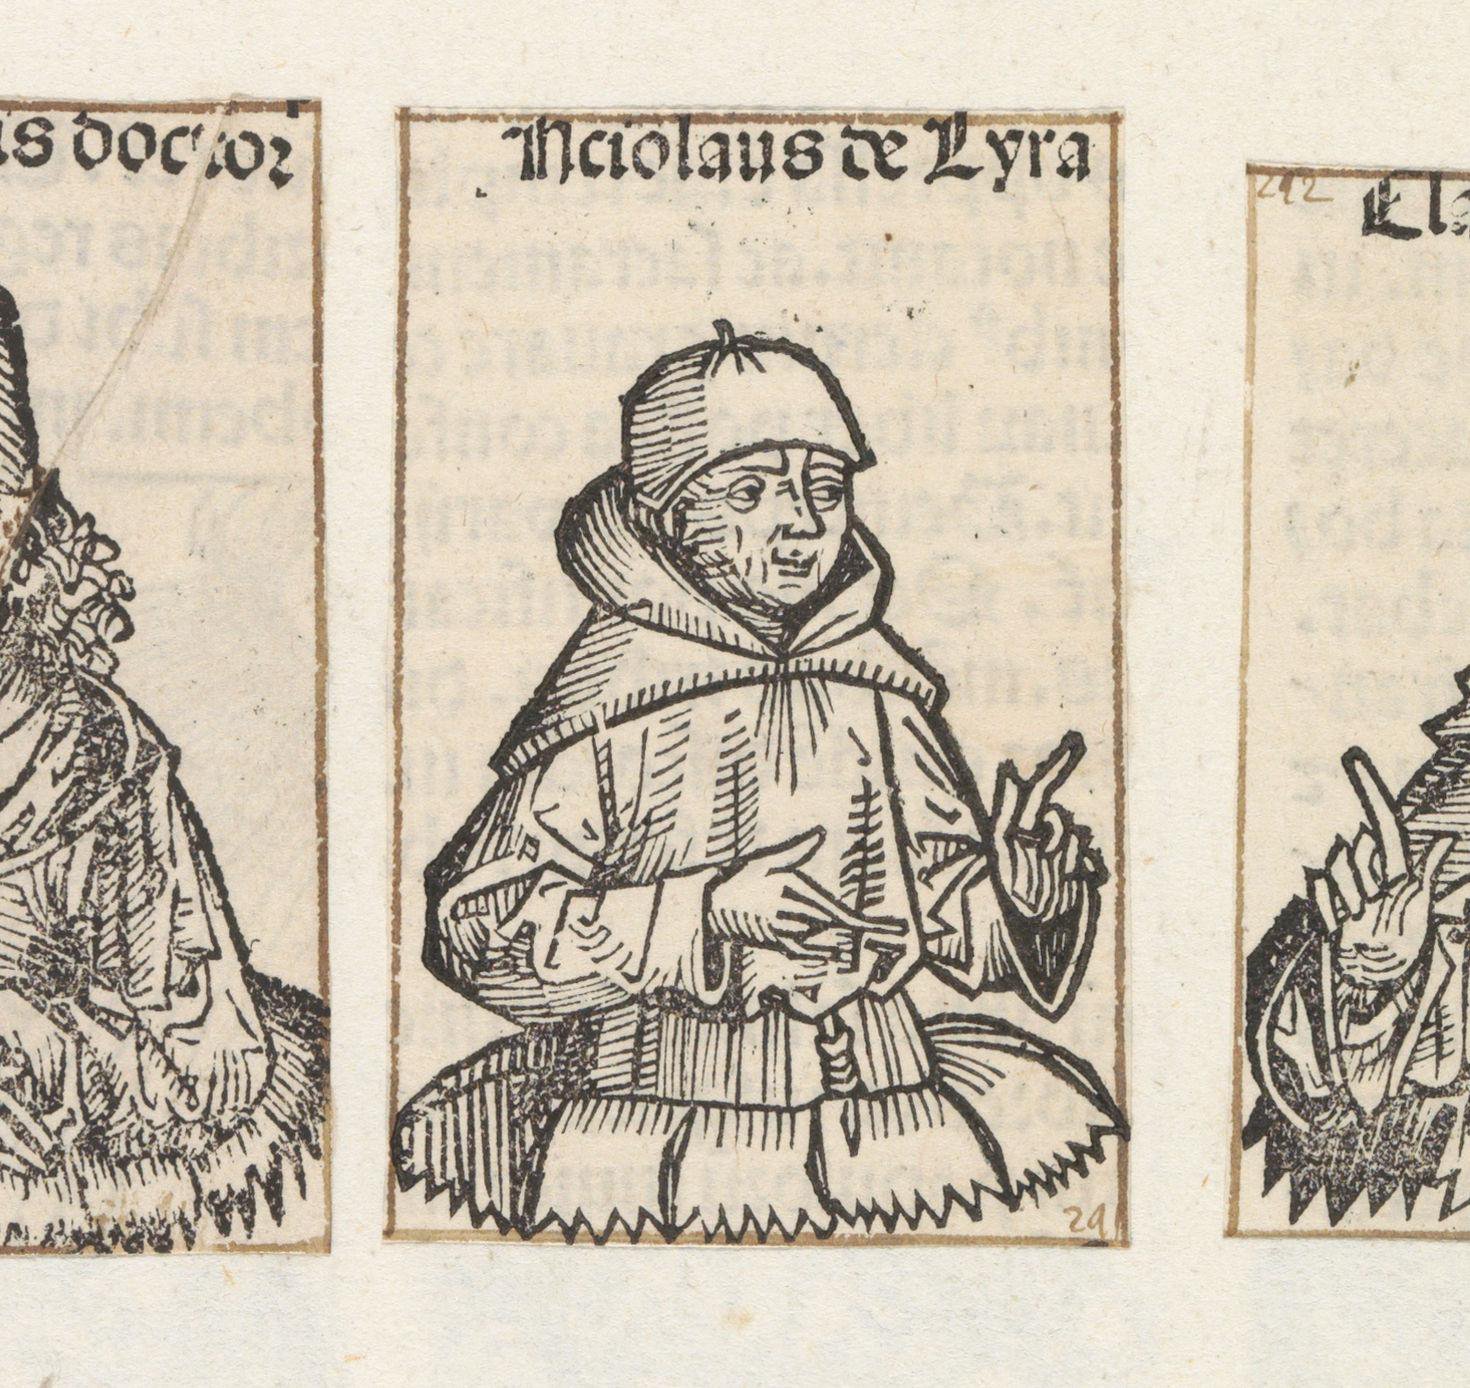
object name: album leaf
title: Nicolaas van Lyra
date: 1493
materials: paper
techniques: letterpress printing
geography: nuremberg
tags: nicolaas van lyra, monk(s), friar(s)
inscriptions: inscription: ‘241’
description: De houtsnede wordt herhaaldelijk gebruikt als boekillustratie in de Liber Chronicarum (of Neurenbergkroniek) van Hartmann Schedel, verschenen in het Latijn en Duits in 1493. Zie de Latijnse uitgave, folio 221r.